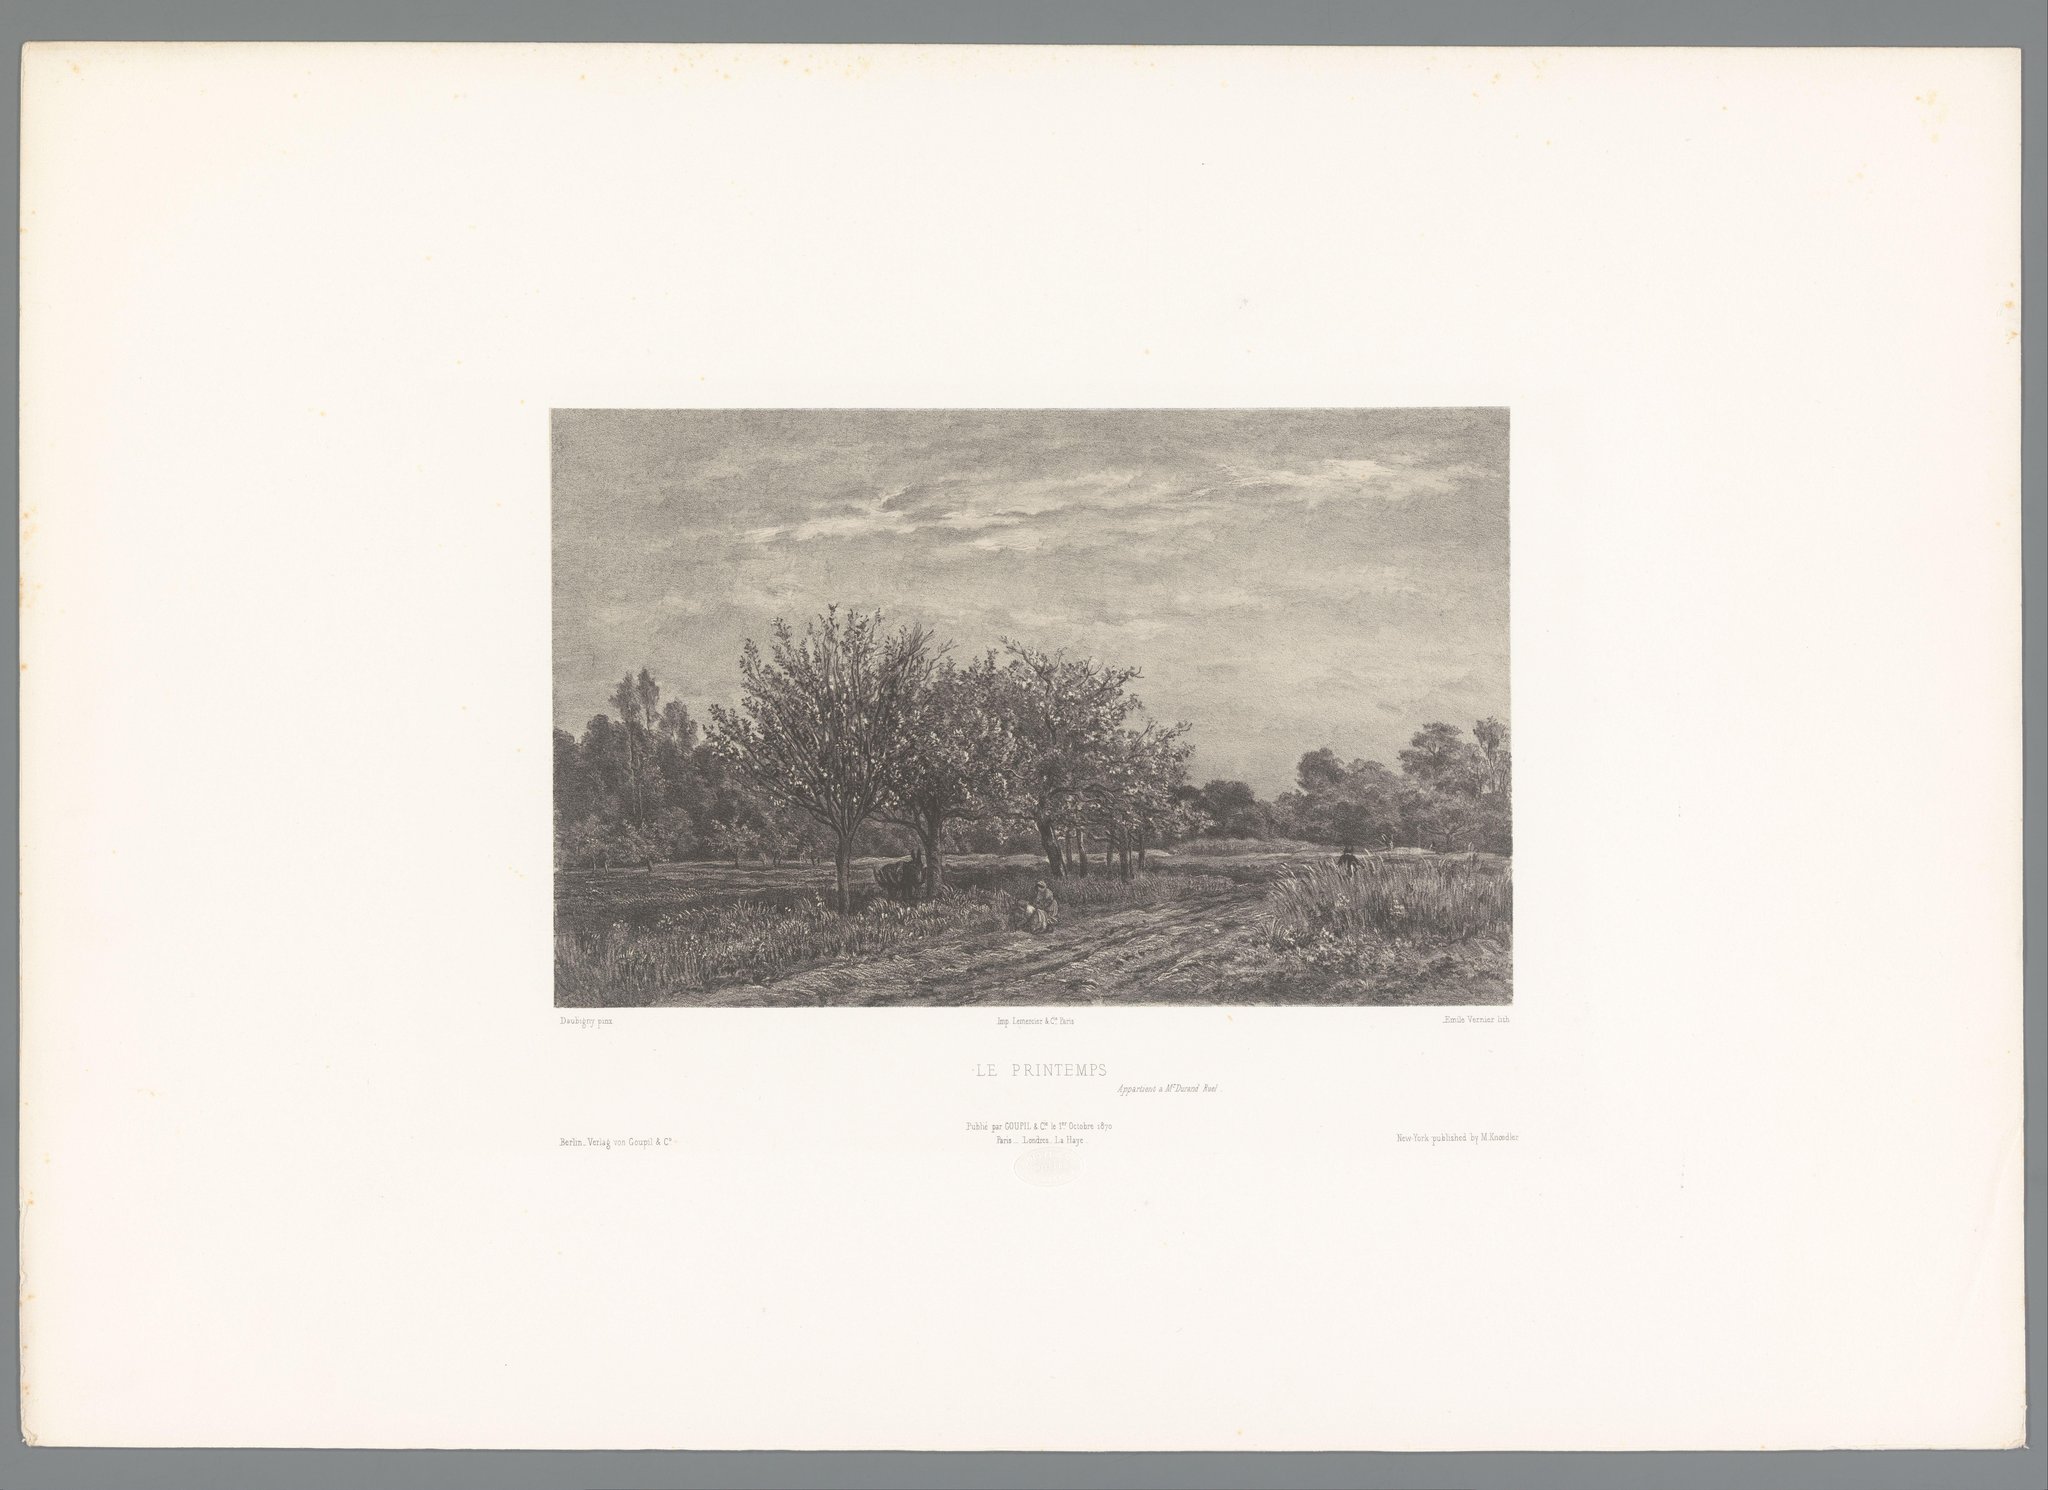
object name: print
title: Landweg met vrouwen en een ezel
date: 1870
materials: paper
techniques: lithograph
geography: the hague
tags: landscapes (+ landscape with figures, staffage)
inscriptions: collector's mark: Lugt 1090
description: Het volgnummer in de serie is niet vermeld.